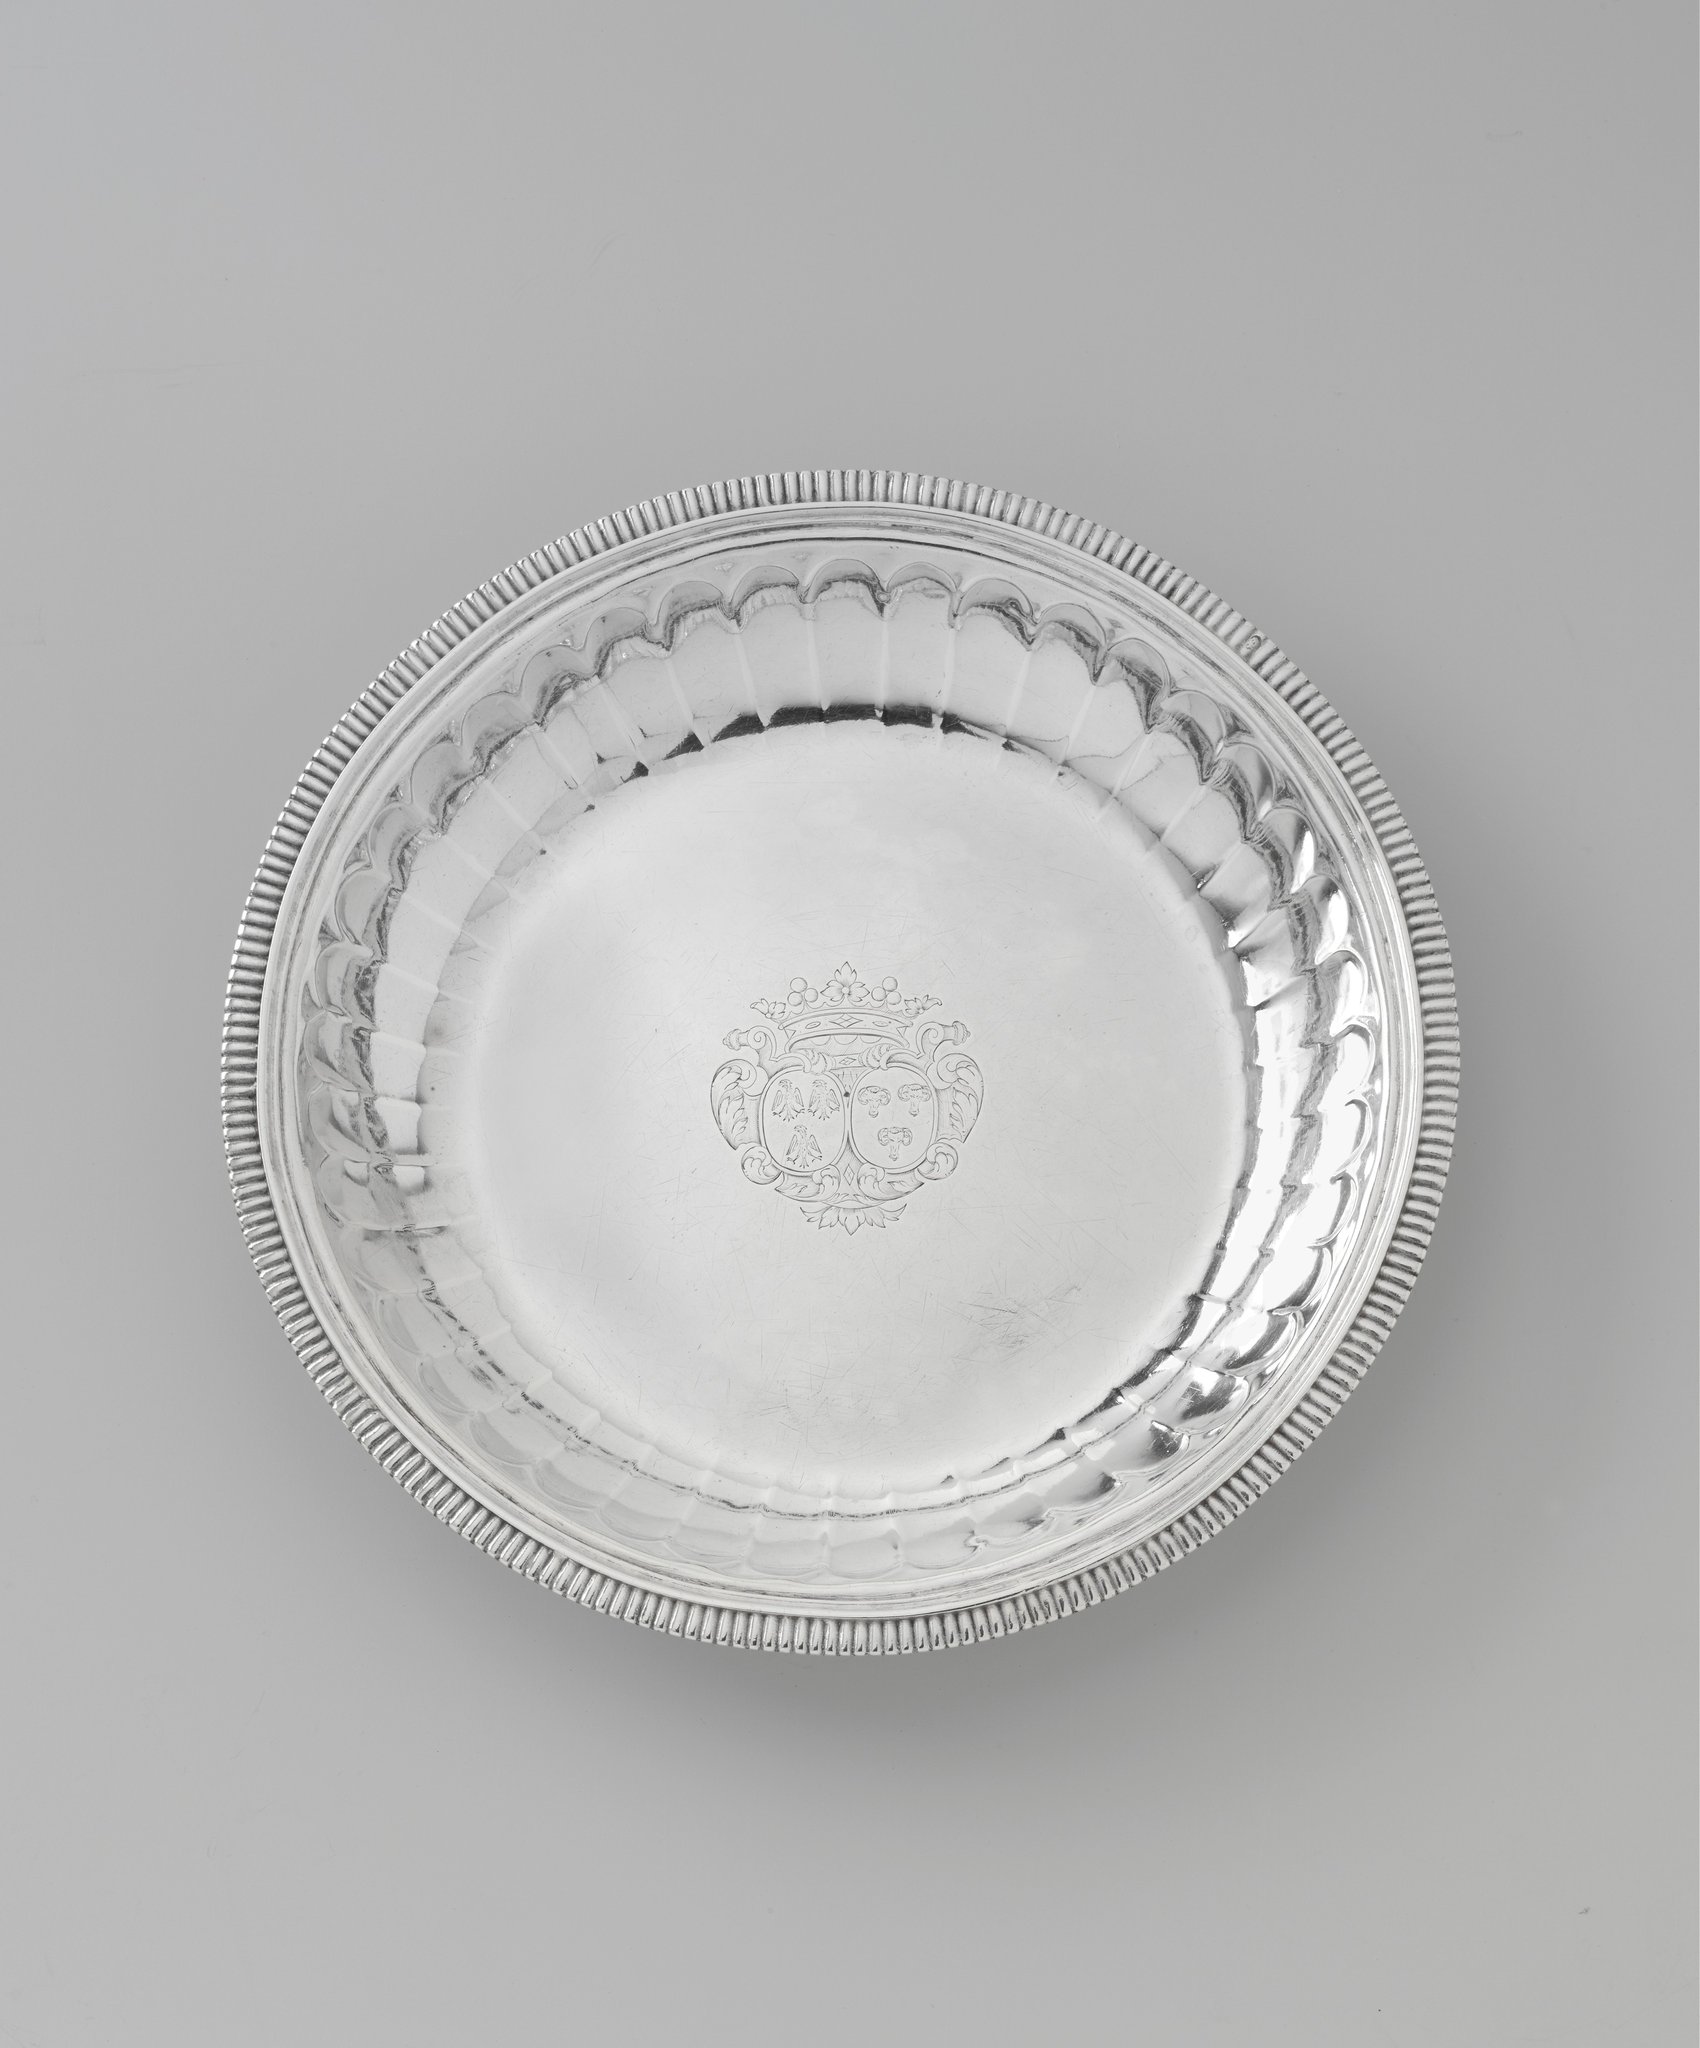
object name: dish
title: Dish (one of a pair)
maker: jérôme rebillé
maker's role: maker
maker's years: 1685-1740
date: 1720-1726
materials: silver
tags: coat of arms